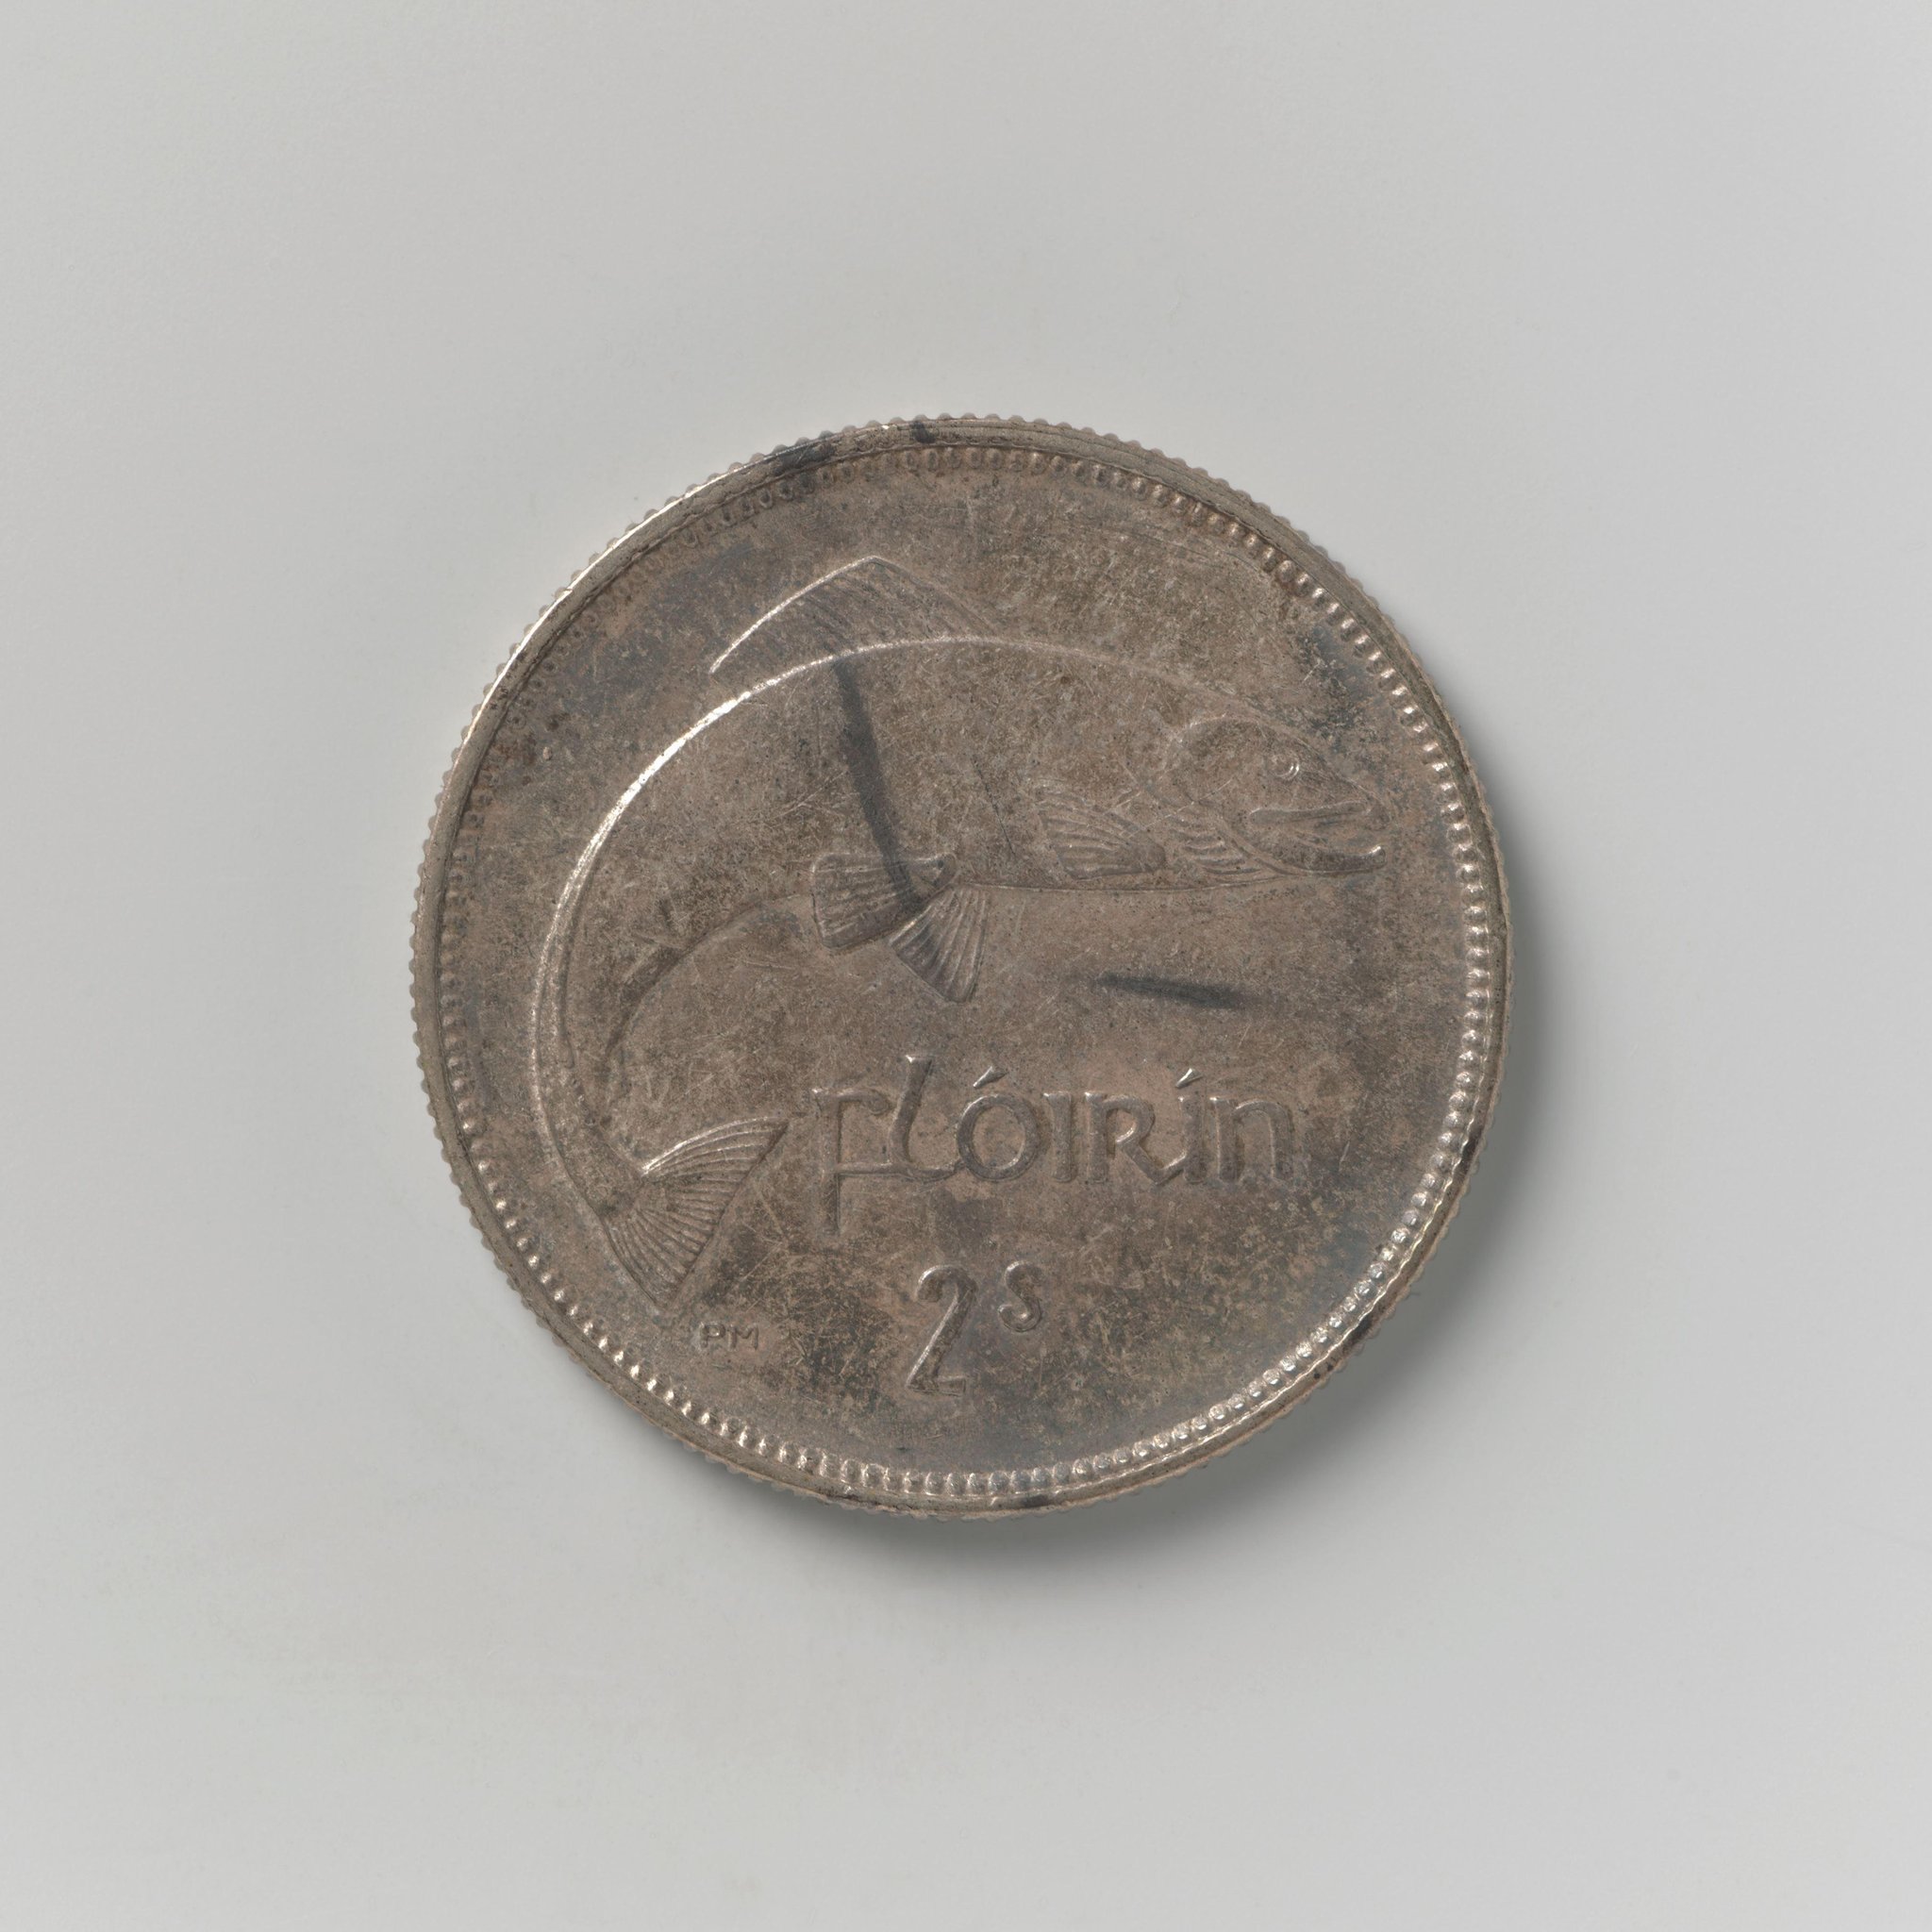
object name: coin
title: Florin uit de republiek Ierland, 1928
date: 1928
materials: nickel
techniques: striking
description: Nikkelen munt. Voorzijde: vis naar rechts. Waarde-aanduidingen floirin en 2 s [=shilling] daaronder. Keerzijde: tussen jaartal harp. Kartelrand.